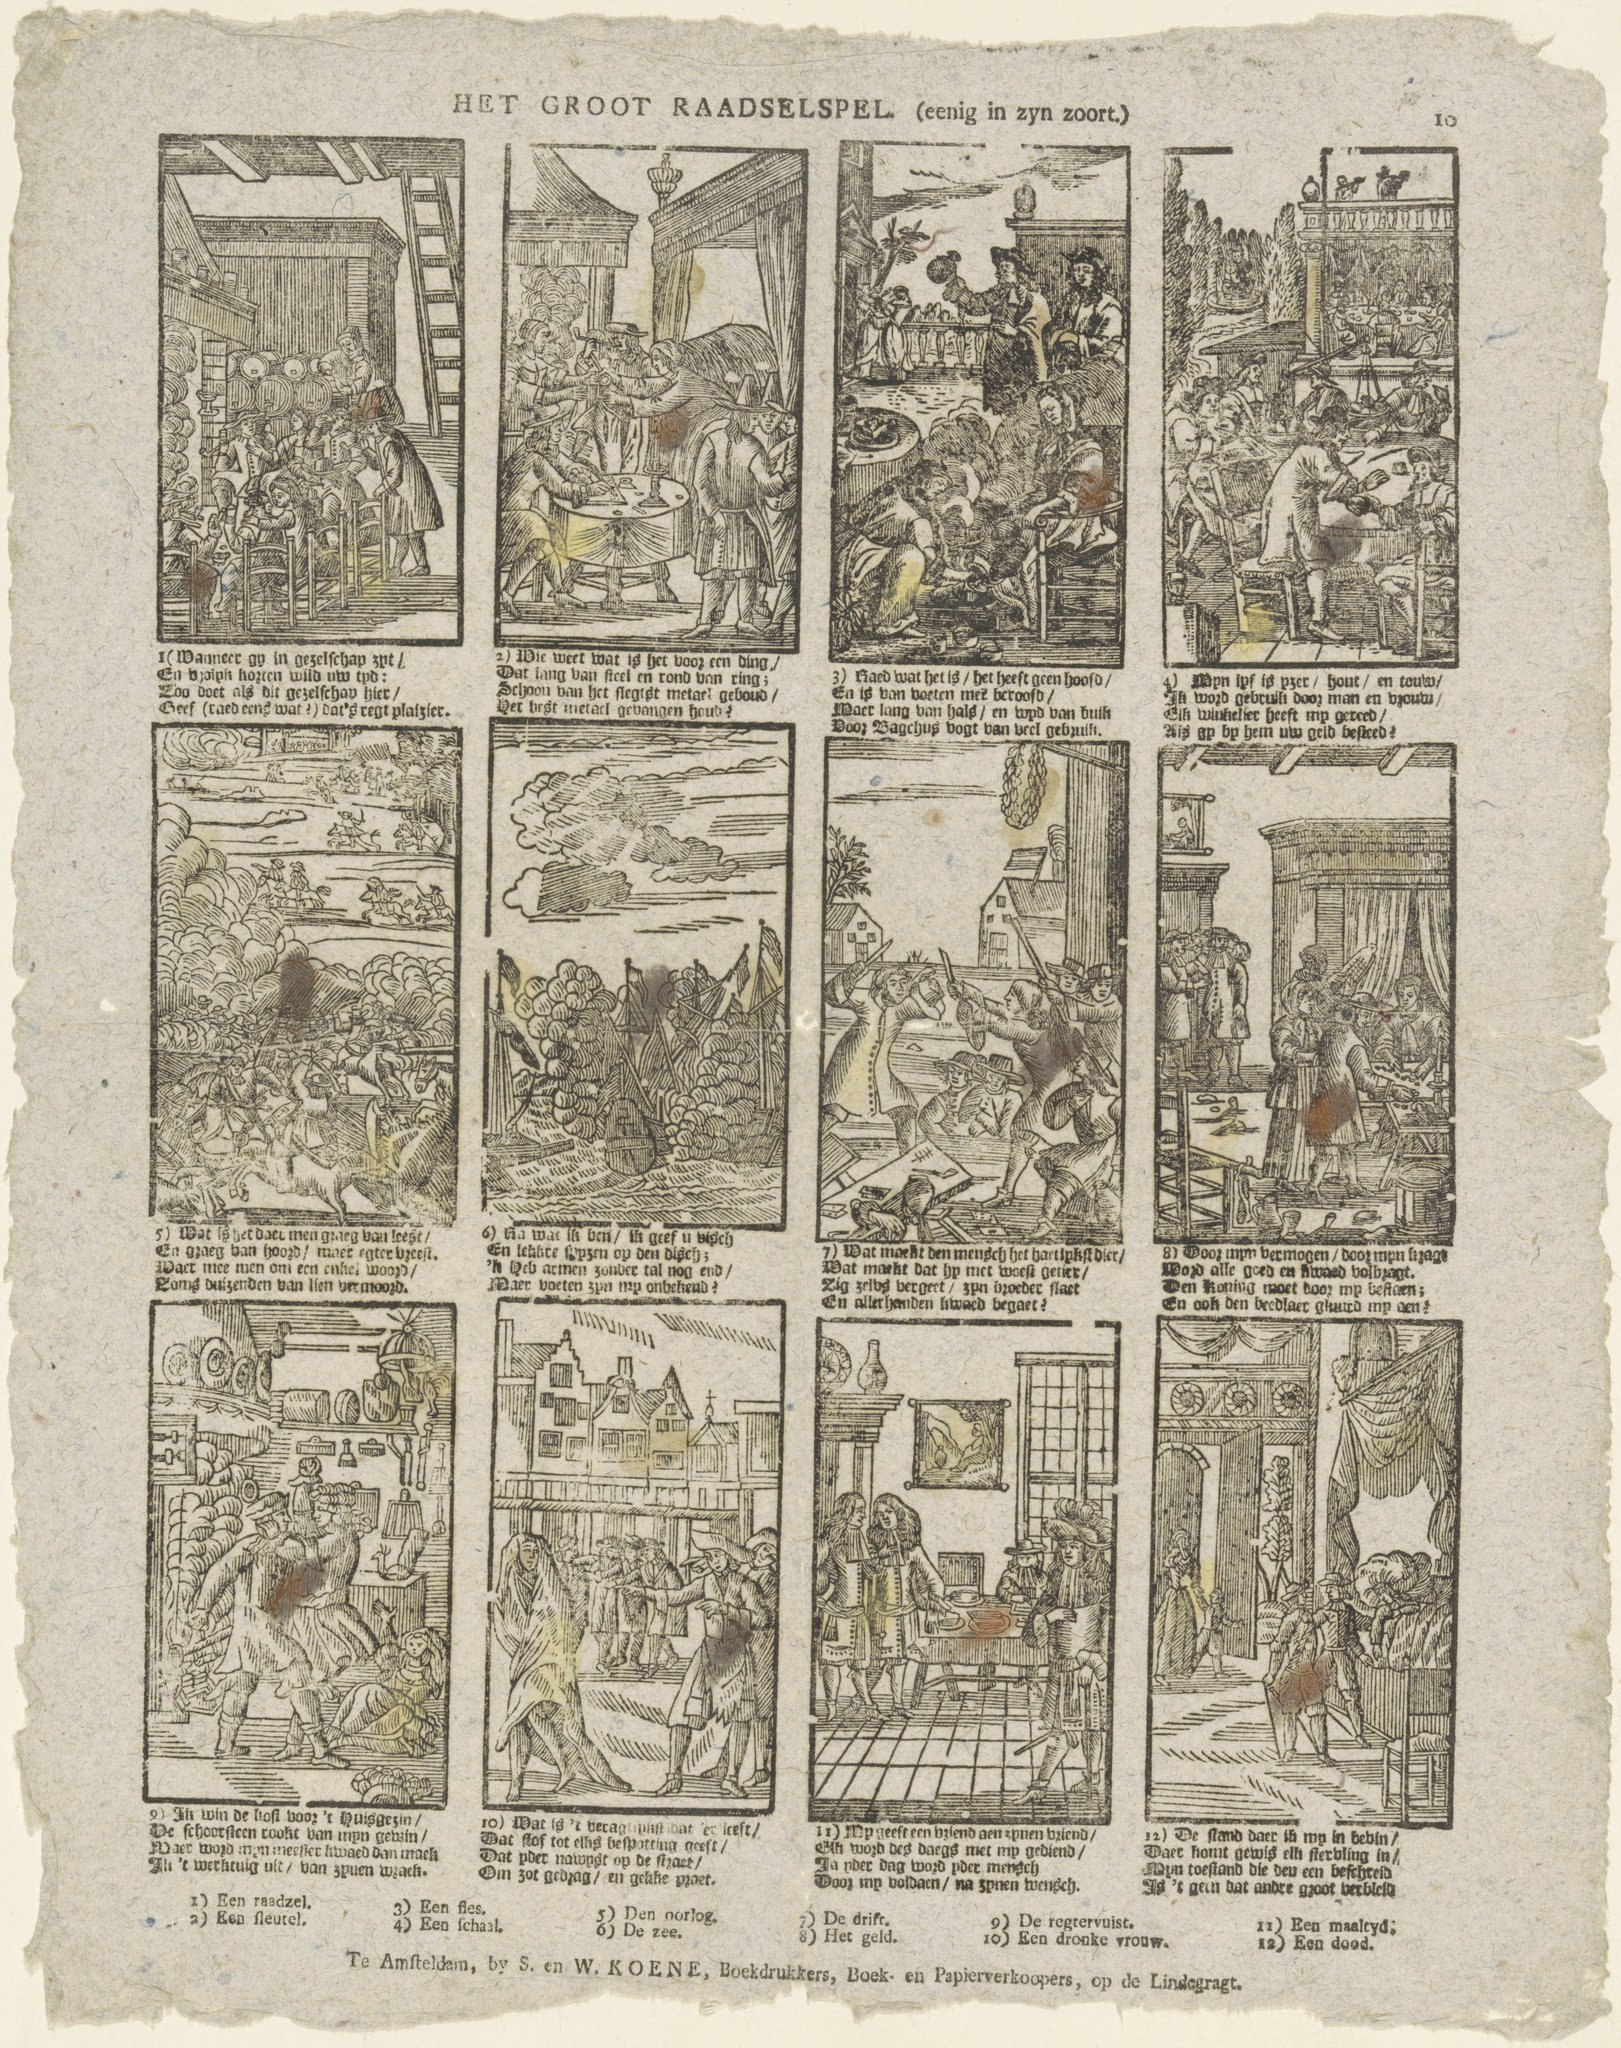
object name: print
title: Het groot raadselspel (eenig in zyn zoort.)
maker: Anonymous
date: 1781-1800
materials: paper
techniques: colour, letterpress printing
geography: amsterdam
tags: tales and fairy tales, puzzle, riddle, conundrum, enigma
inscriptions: collector's mark: Lugt 2760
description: Blad met 12 illustraties uit een zeventiende-eeuws boek, met onderschriften geformuleerd als raadsels. Genummerd rechtsboven: 10.